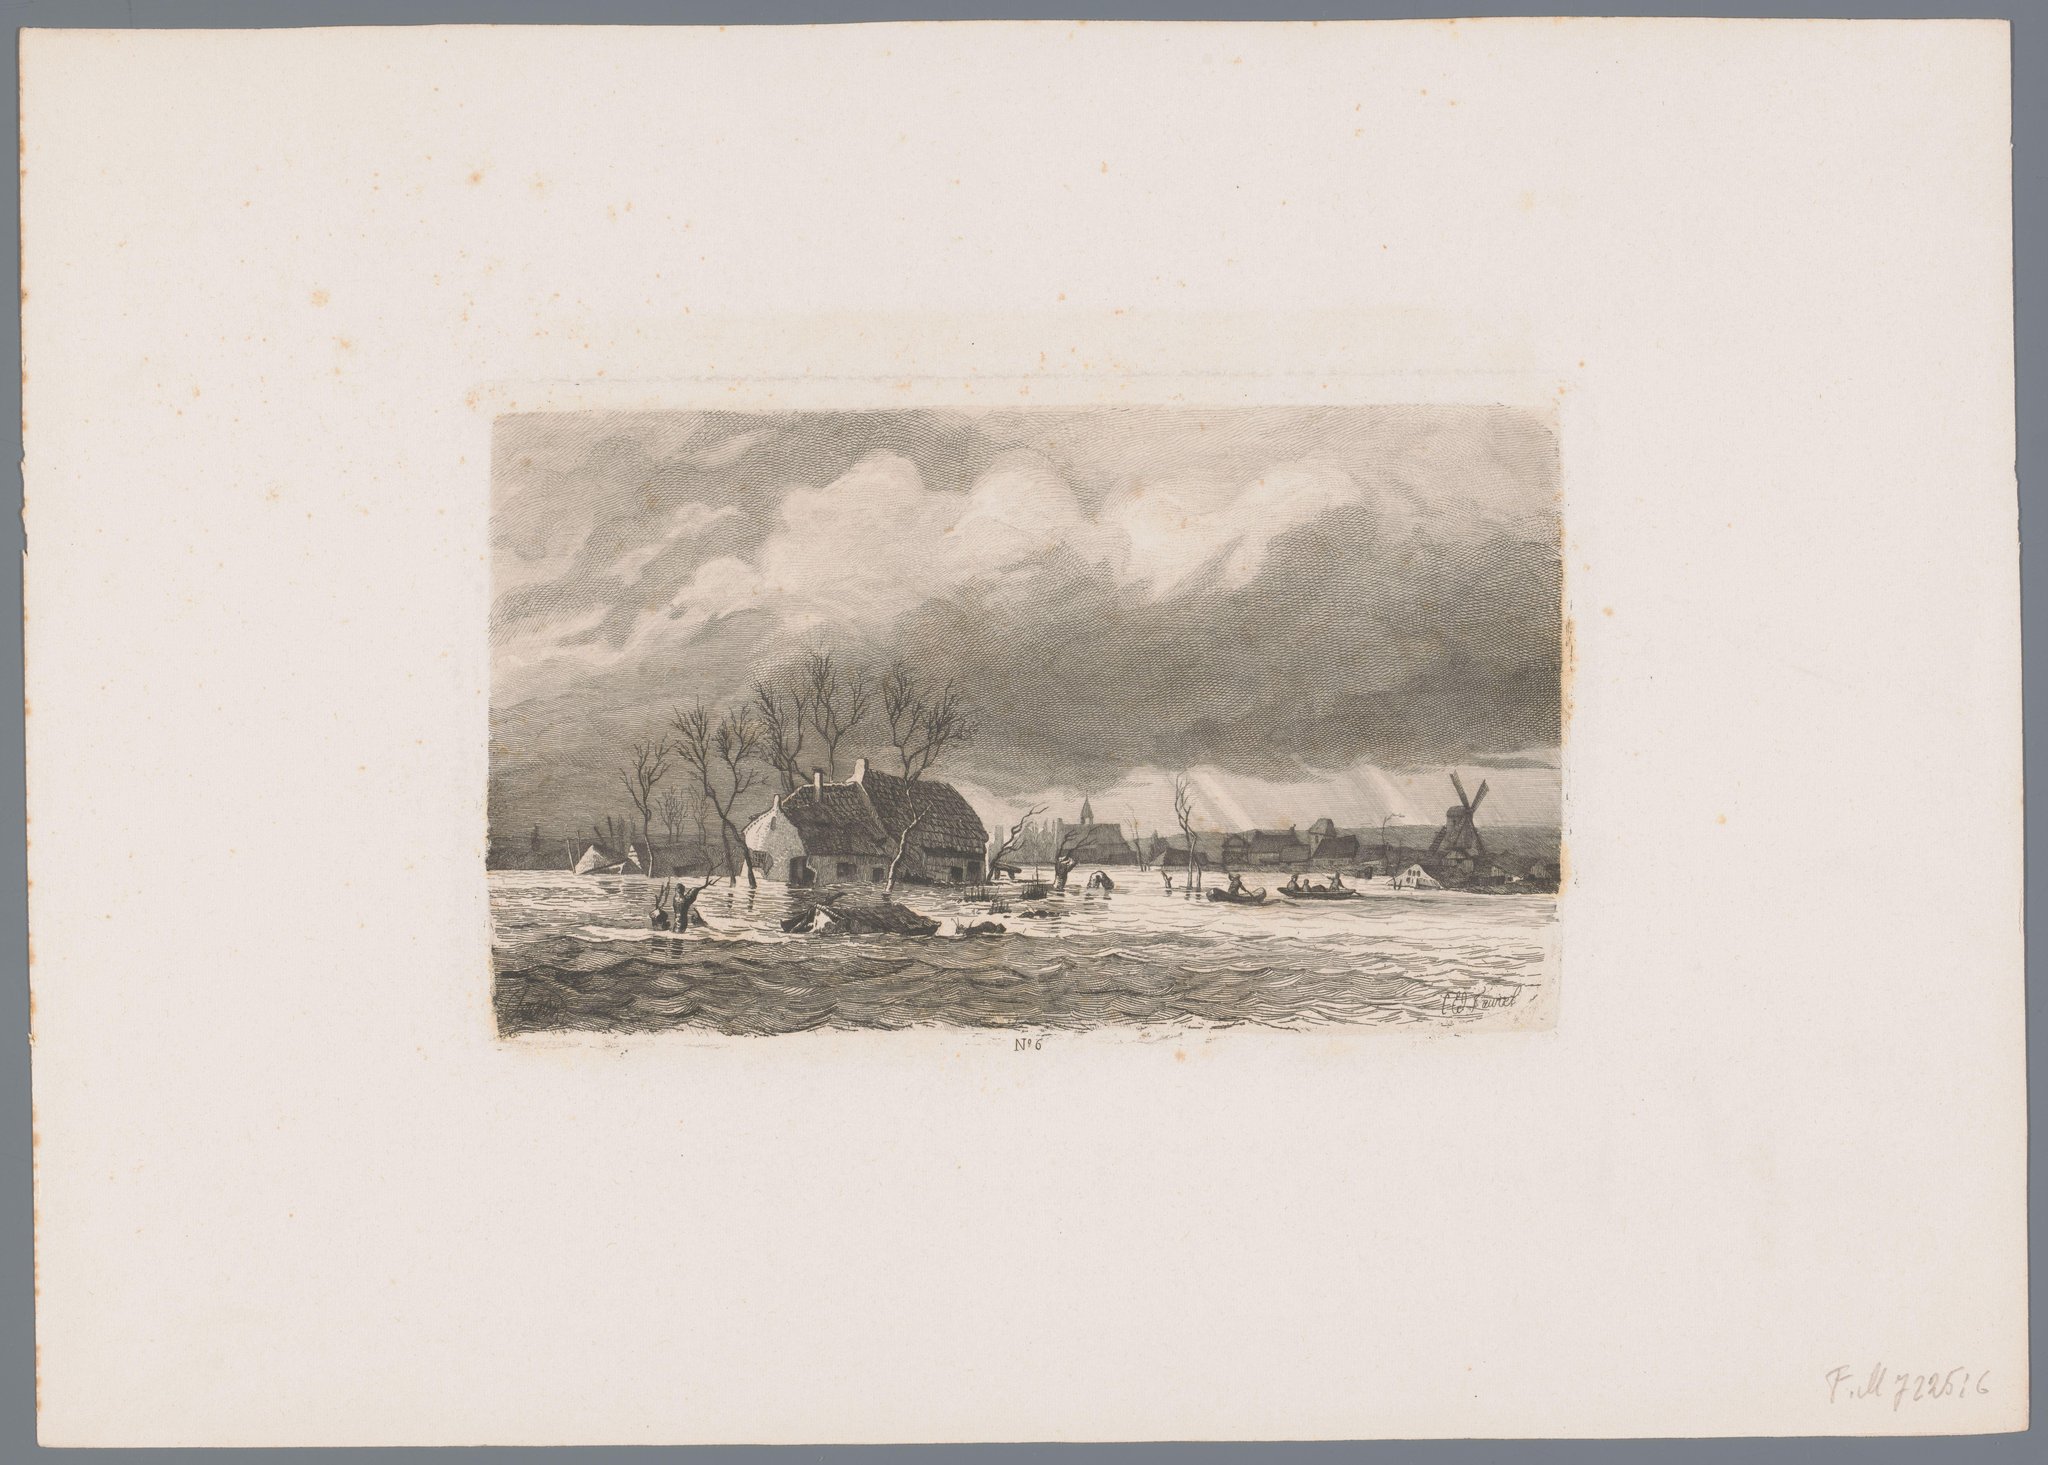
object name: print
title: Veenendaal van de Klomp gezien, 24 Maart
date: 1855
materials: paper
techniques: etching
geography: netherlands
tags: flood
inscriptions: collector's mark: Lugt 2228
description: Gezicht op Veenendaal vanaf de Klomp, 24 maart 1855. Op de voorgrond een onder water staande boerderij. Onderdeel van de reeks van 24 prenten over de watersnood van maart 1855, door leden van het genootschap Arti et Amicitiae. Uitgave ten behoeve van de slachtoffers van de watersnood.